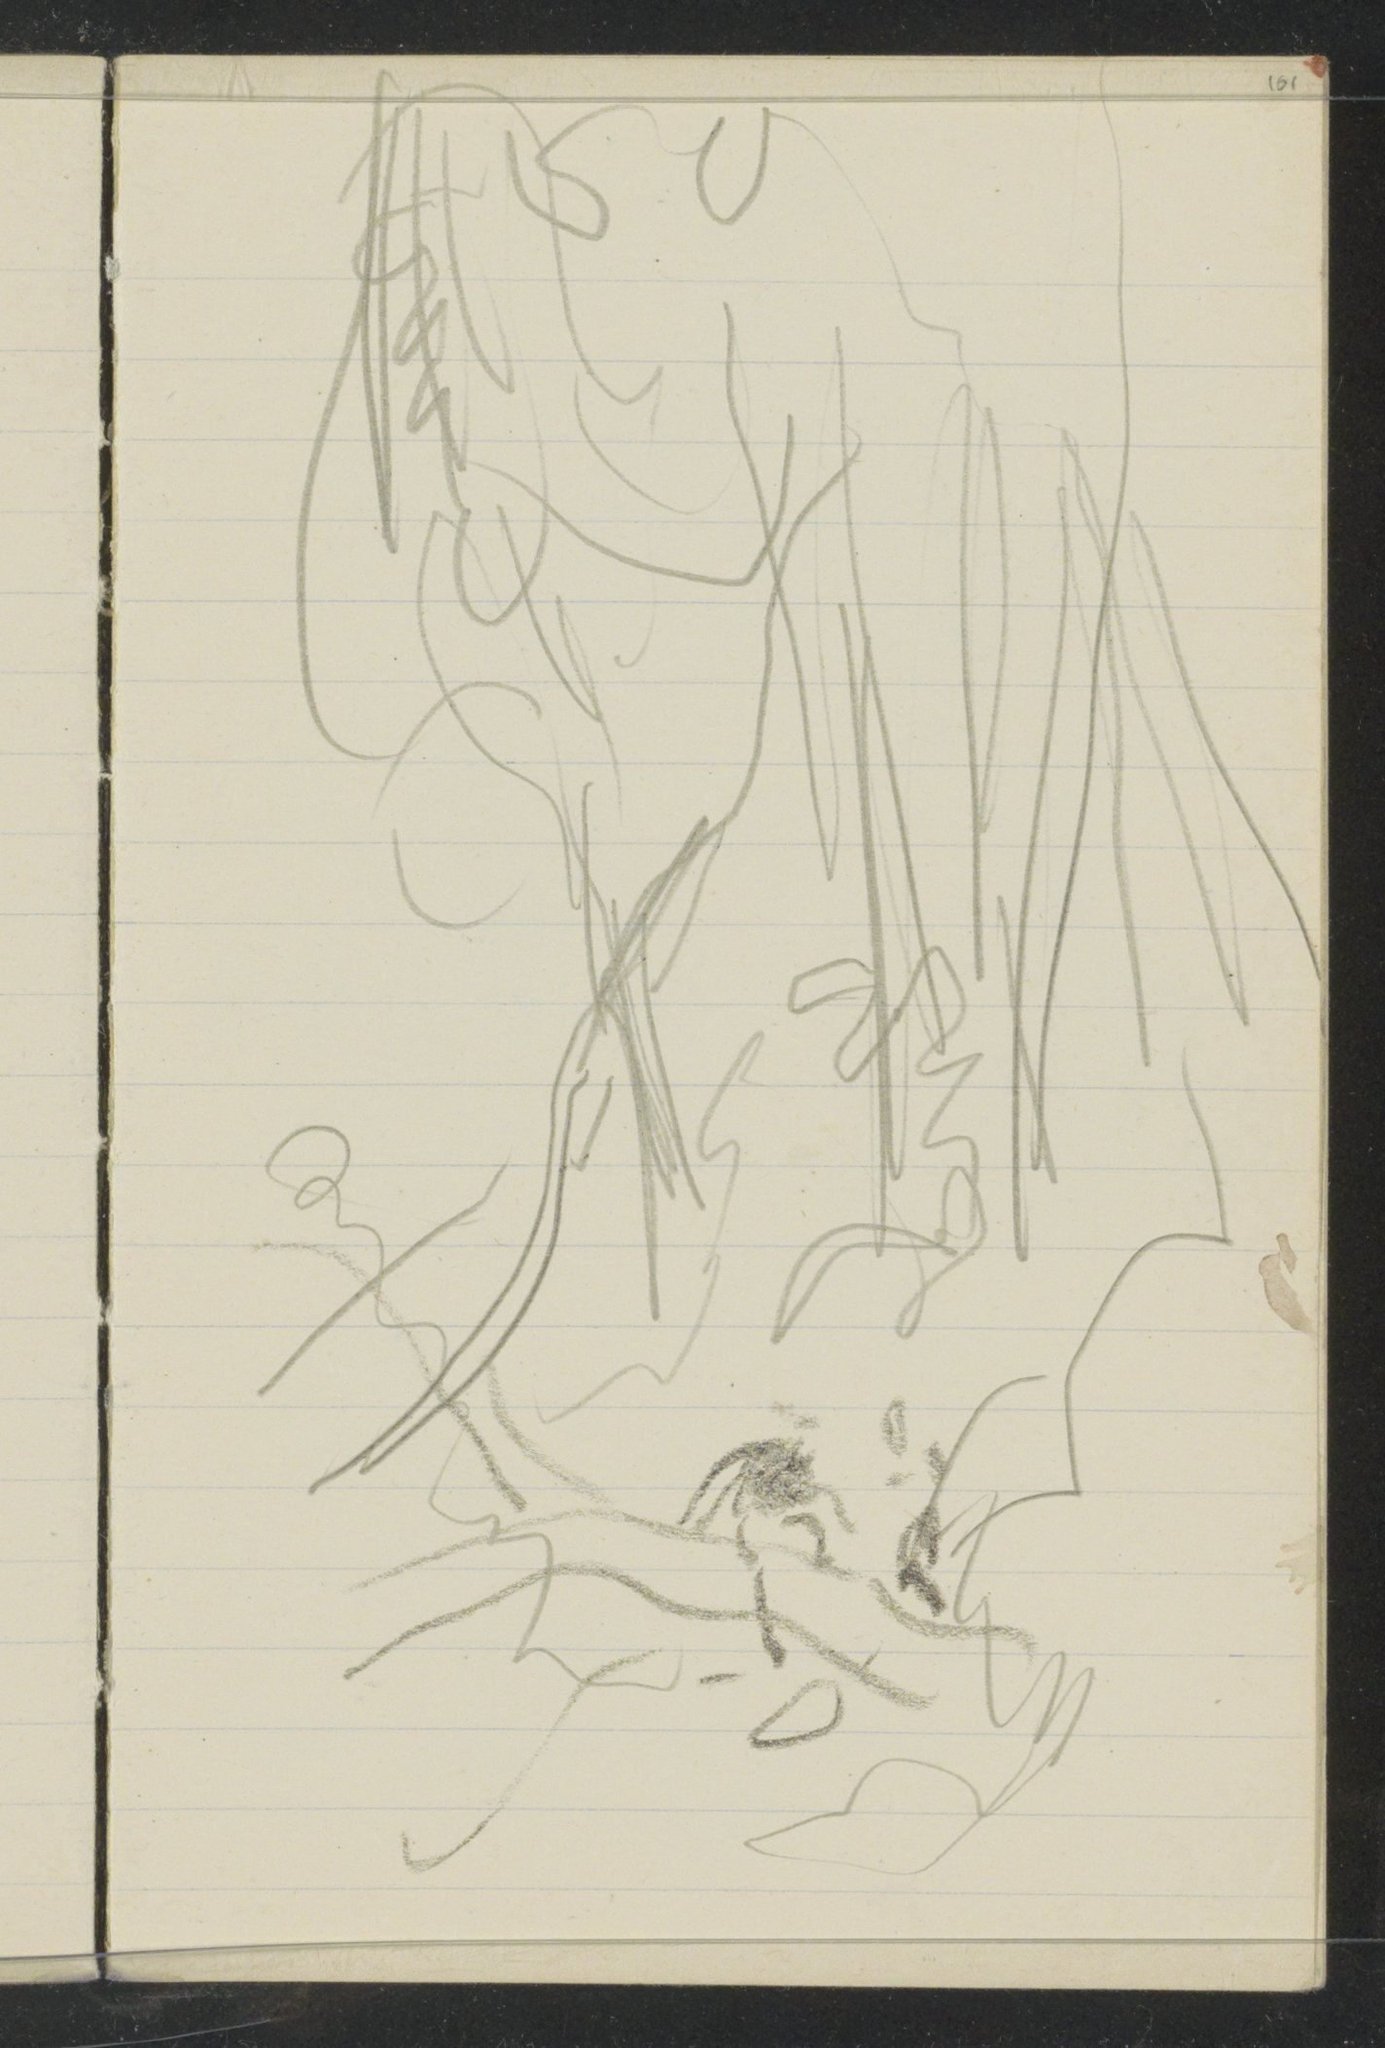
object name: sketchbook leaf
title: Boom bij een rivier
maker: marius bauer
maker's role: draughtsman, print maker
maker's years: 1867-1932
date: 1931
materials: chalk, pencil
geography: indonesia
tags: trees, river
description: Pagina 101 uit een schetsboek met 74 bladen.